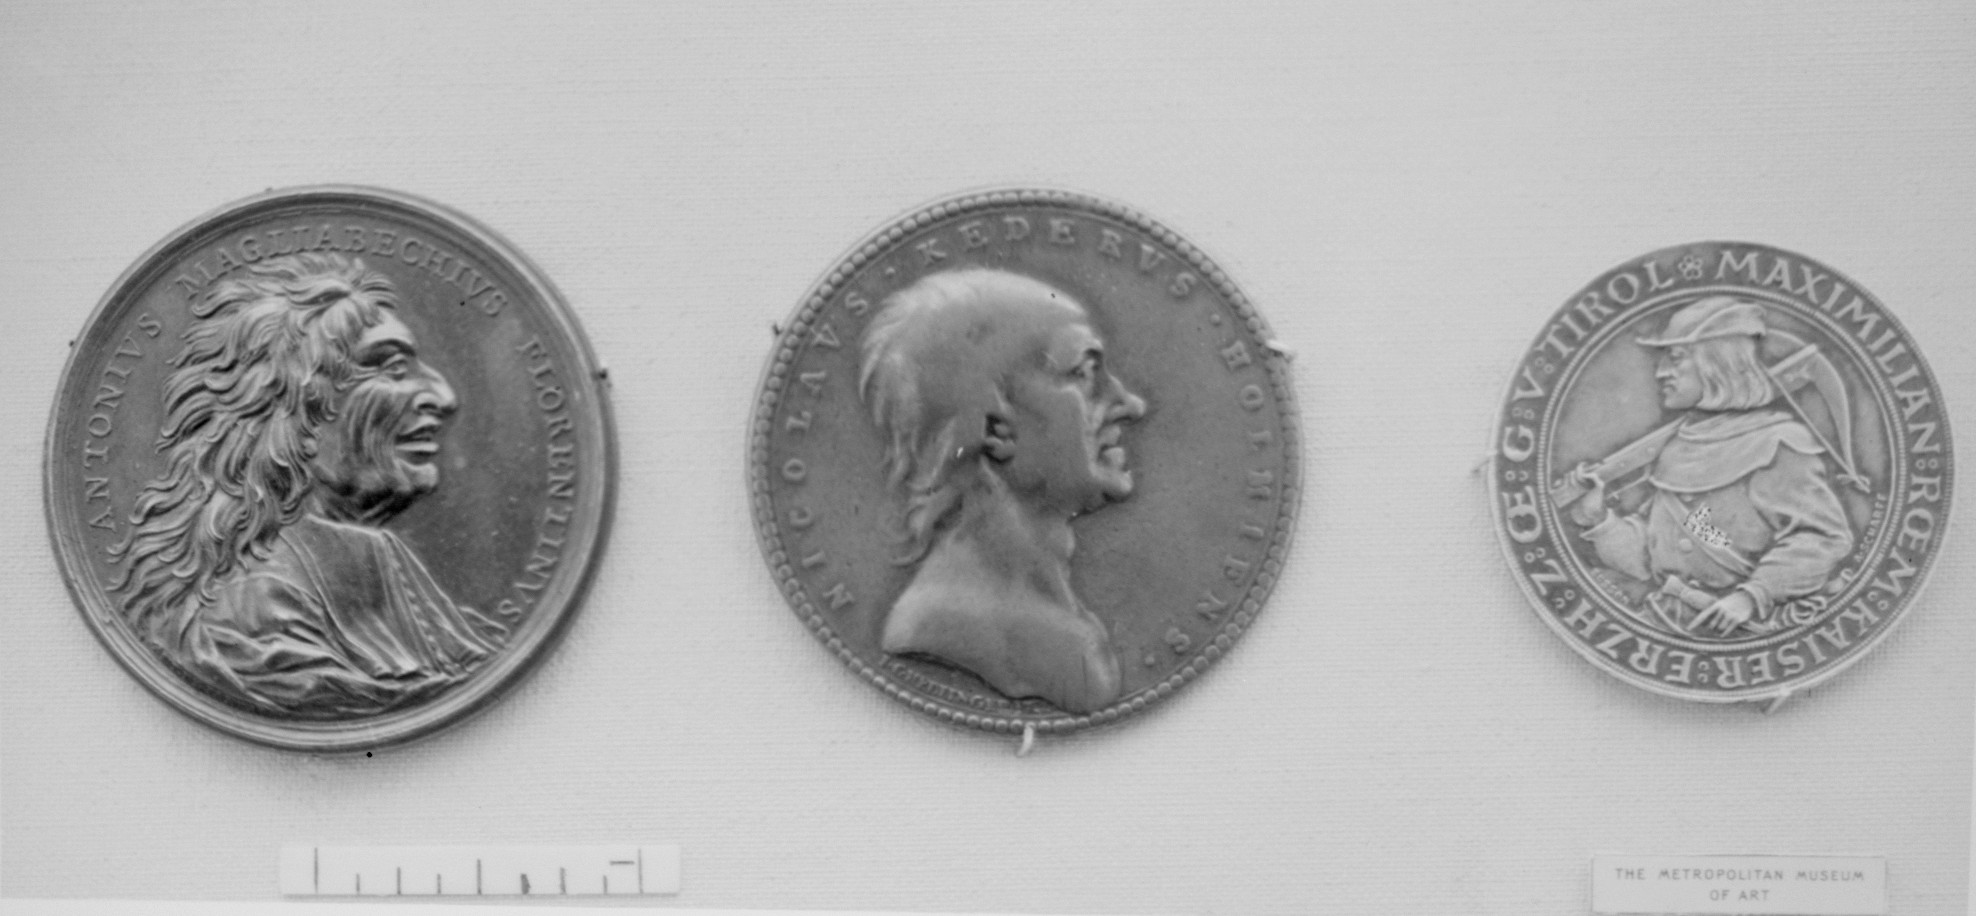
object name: medal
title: In Honor of Nicholas Keder, the Swedish antiquarian (1695–1735)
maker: johann carl hedlinger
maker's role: artist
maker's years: 1691-1771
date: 1701-1800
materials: bronze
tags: men,profiles